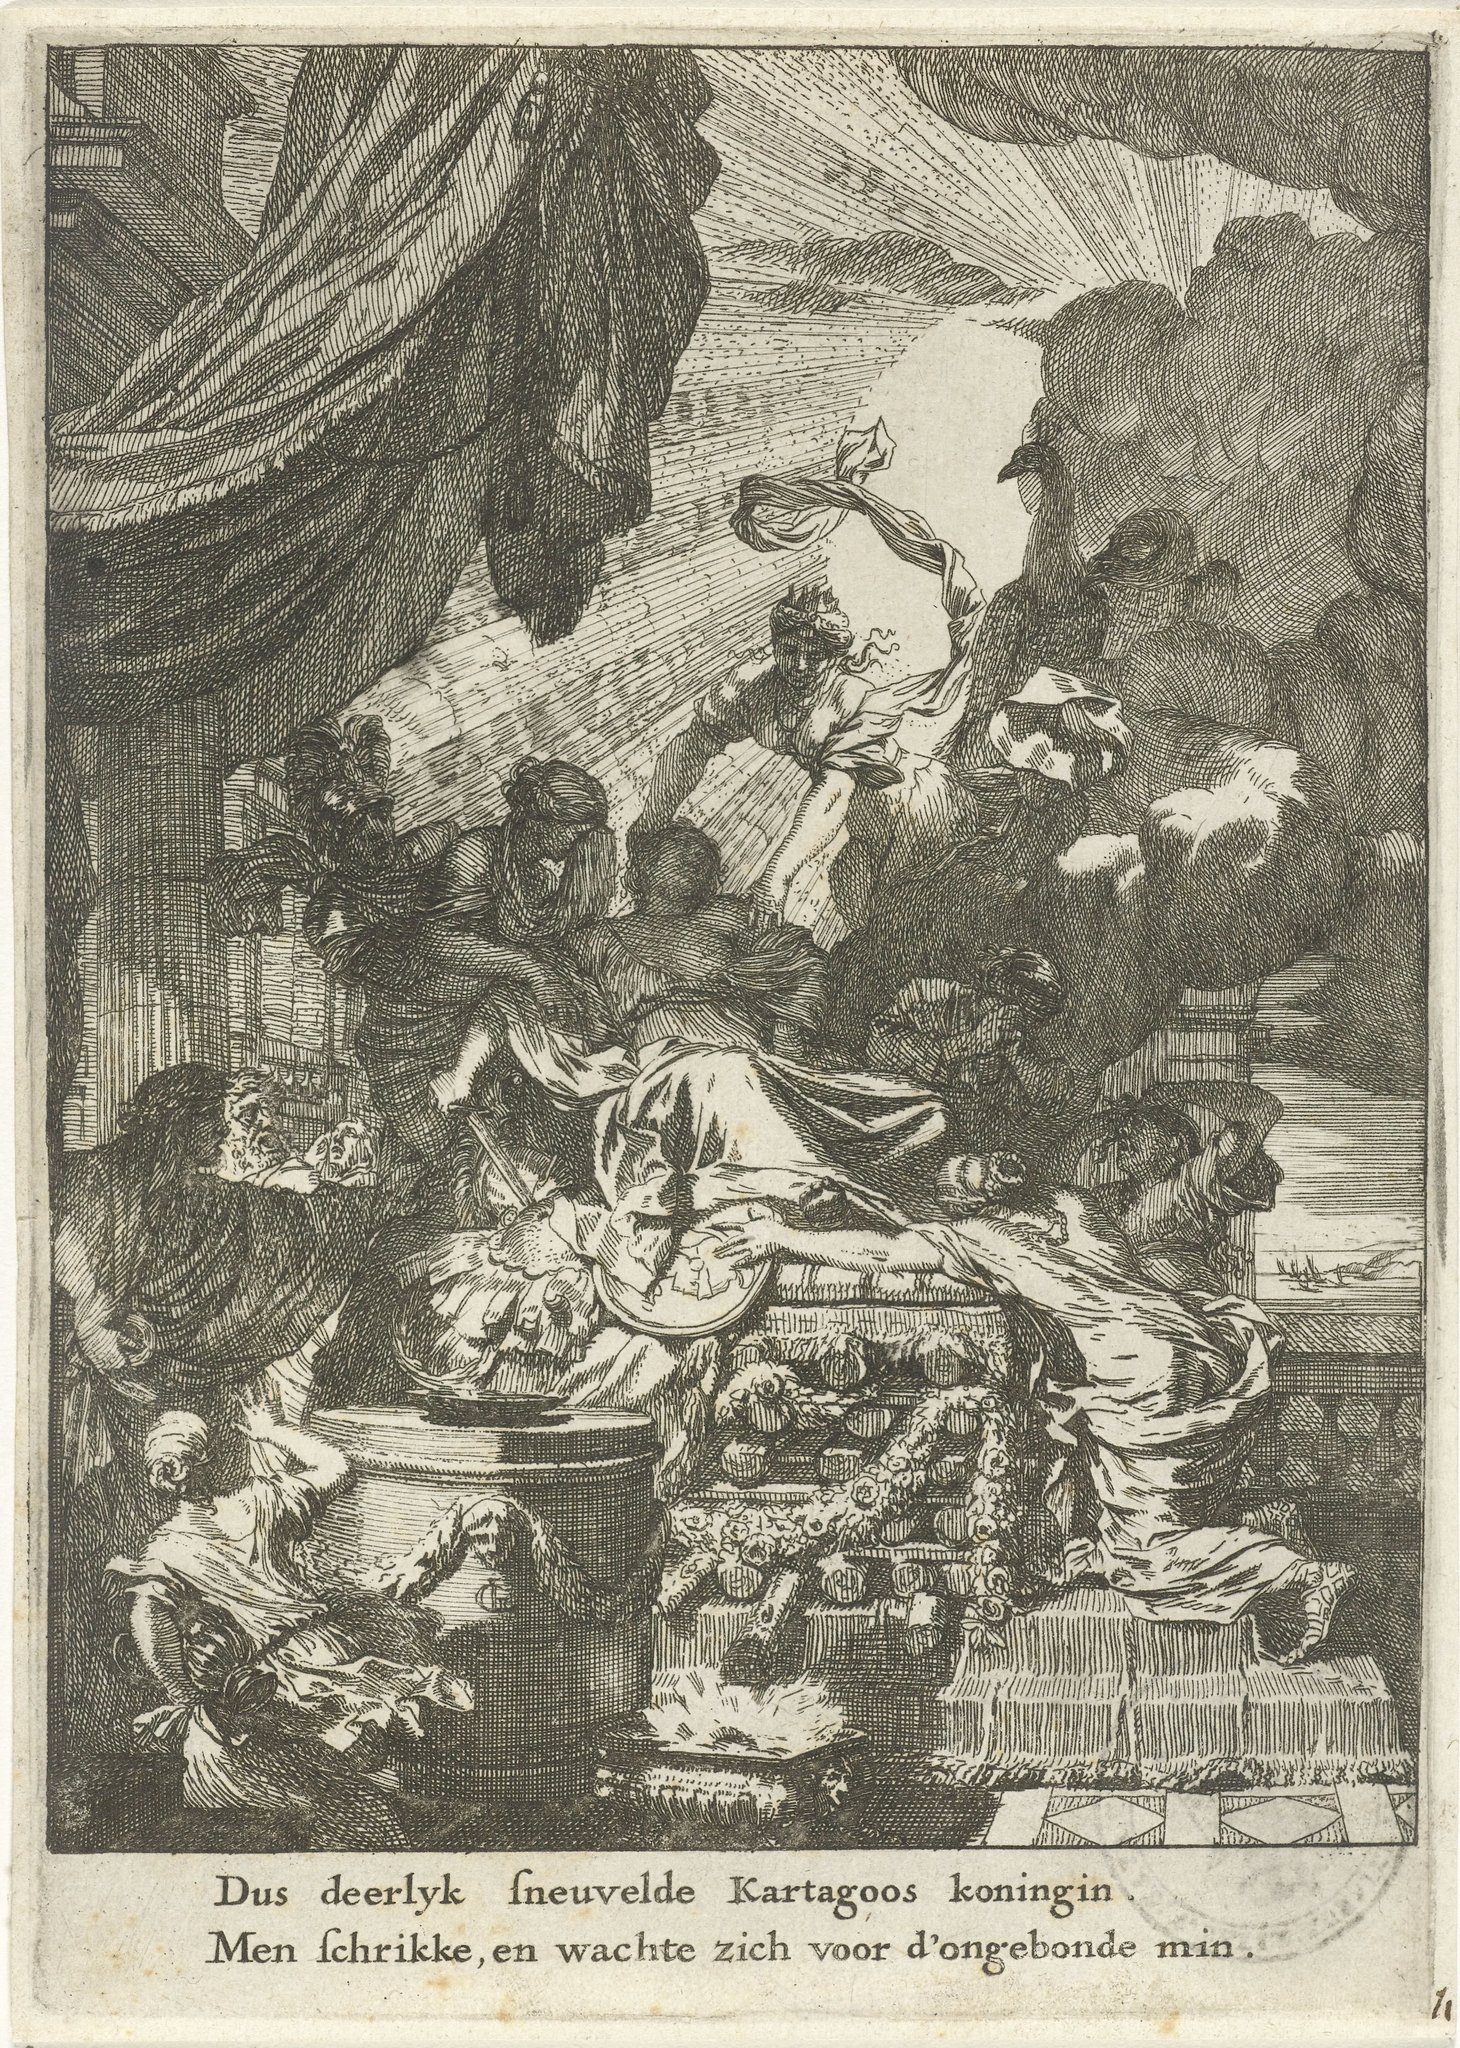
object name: print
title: Dood van Dido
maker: gerard de lairesse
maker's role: draughtsman, painter, print maker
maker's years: 1641-1711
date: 1668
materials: paper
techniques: etching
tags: (story of) dido - death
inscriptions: collector's mark: Lugt 10, number: ‘4’, collector's mark: Lugt 11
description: Dido heeft zichzelf met het zwaard van Aeneas doorboord nadat haar geliefde per boot is vertrokken. Ze ligt op de brandstapel, opgebouwd uit bezittingen van Aeneas, die zij zelf heeft laten oprichten. Iris, de vrouwelijke boodschapper van Juno, is achter Dido verschenen om een haarlok af te knippen. Links staat Dido's zuster Anna in grote wanhoop. In de marge staat een tweeregelig onderschrift in het Nederlands. Deze illustratie is vervaardigd bij het derde bedrijf van het treurspel "Didoos Doot" (1668), geschreven door Andries Pels. De prent maakt deel uit van een vierdelige serie met scènes uit dit treurspel.